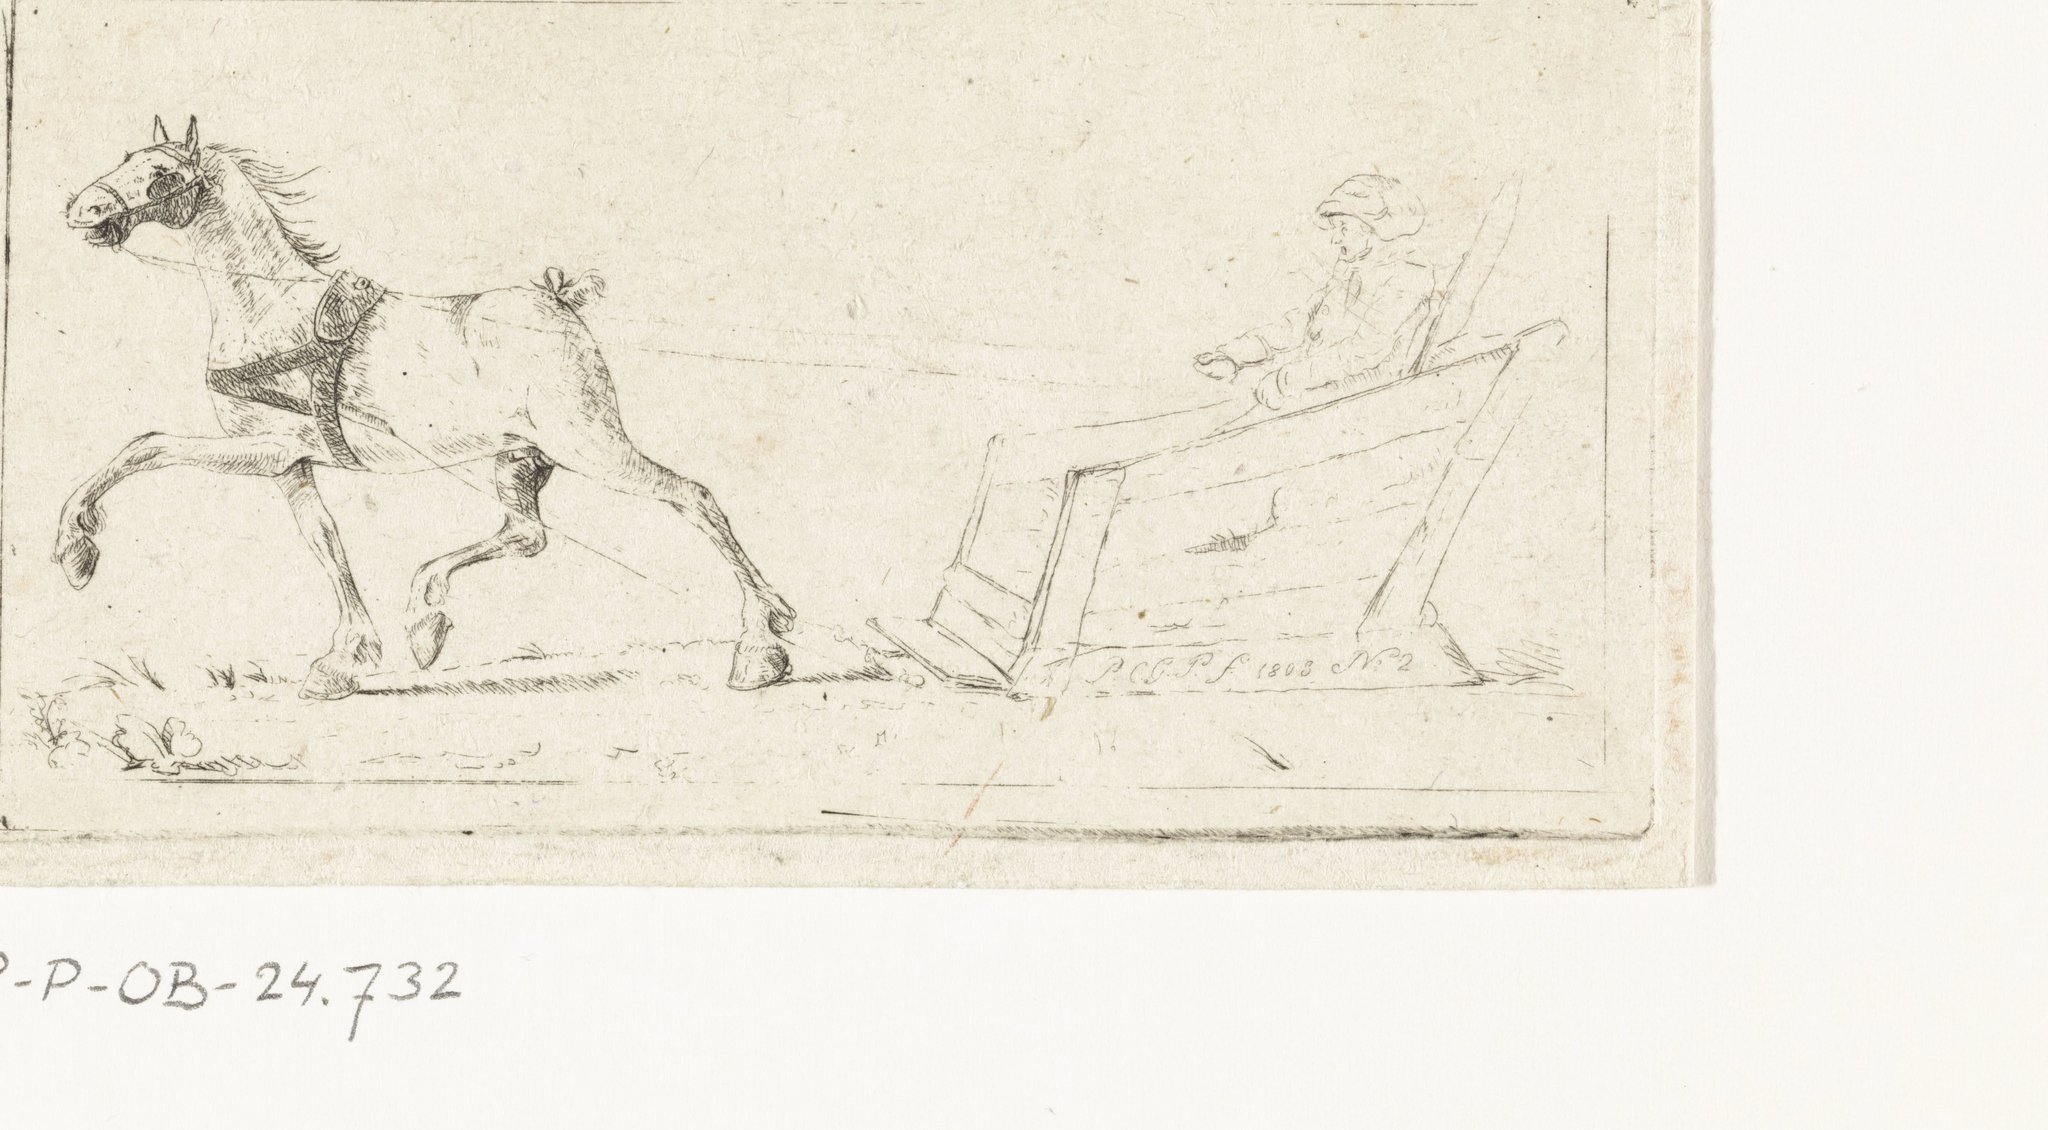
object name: print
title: Paard met slee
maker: paulus charles gerard poelman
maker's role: draughtsman, painter, print maker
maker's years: 1792-1846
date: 1803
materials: paper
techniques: etching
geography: utrecht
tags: horse-sleigh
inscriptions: inscription, collector's mark: Lugt 2228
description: Een paard trekt een houten slee met een man er in. Op de slee 'No. 2'.